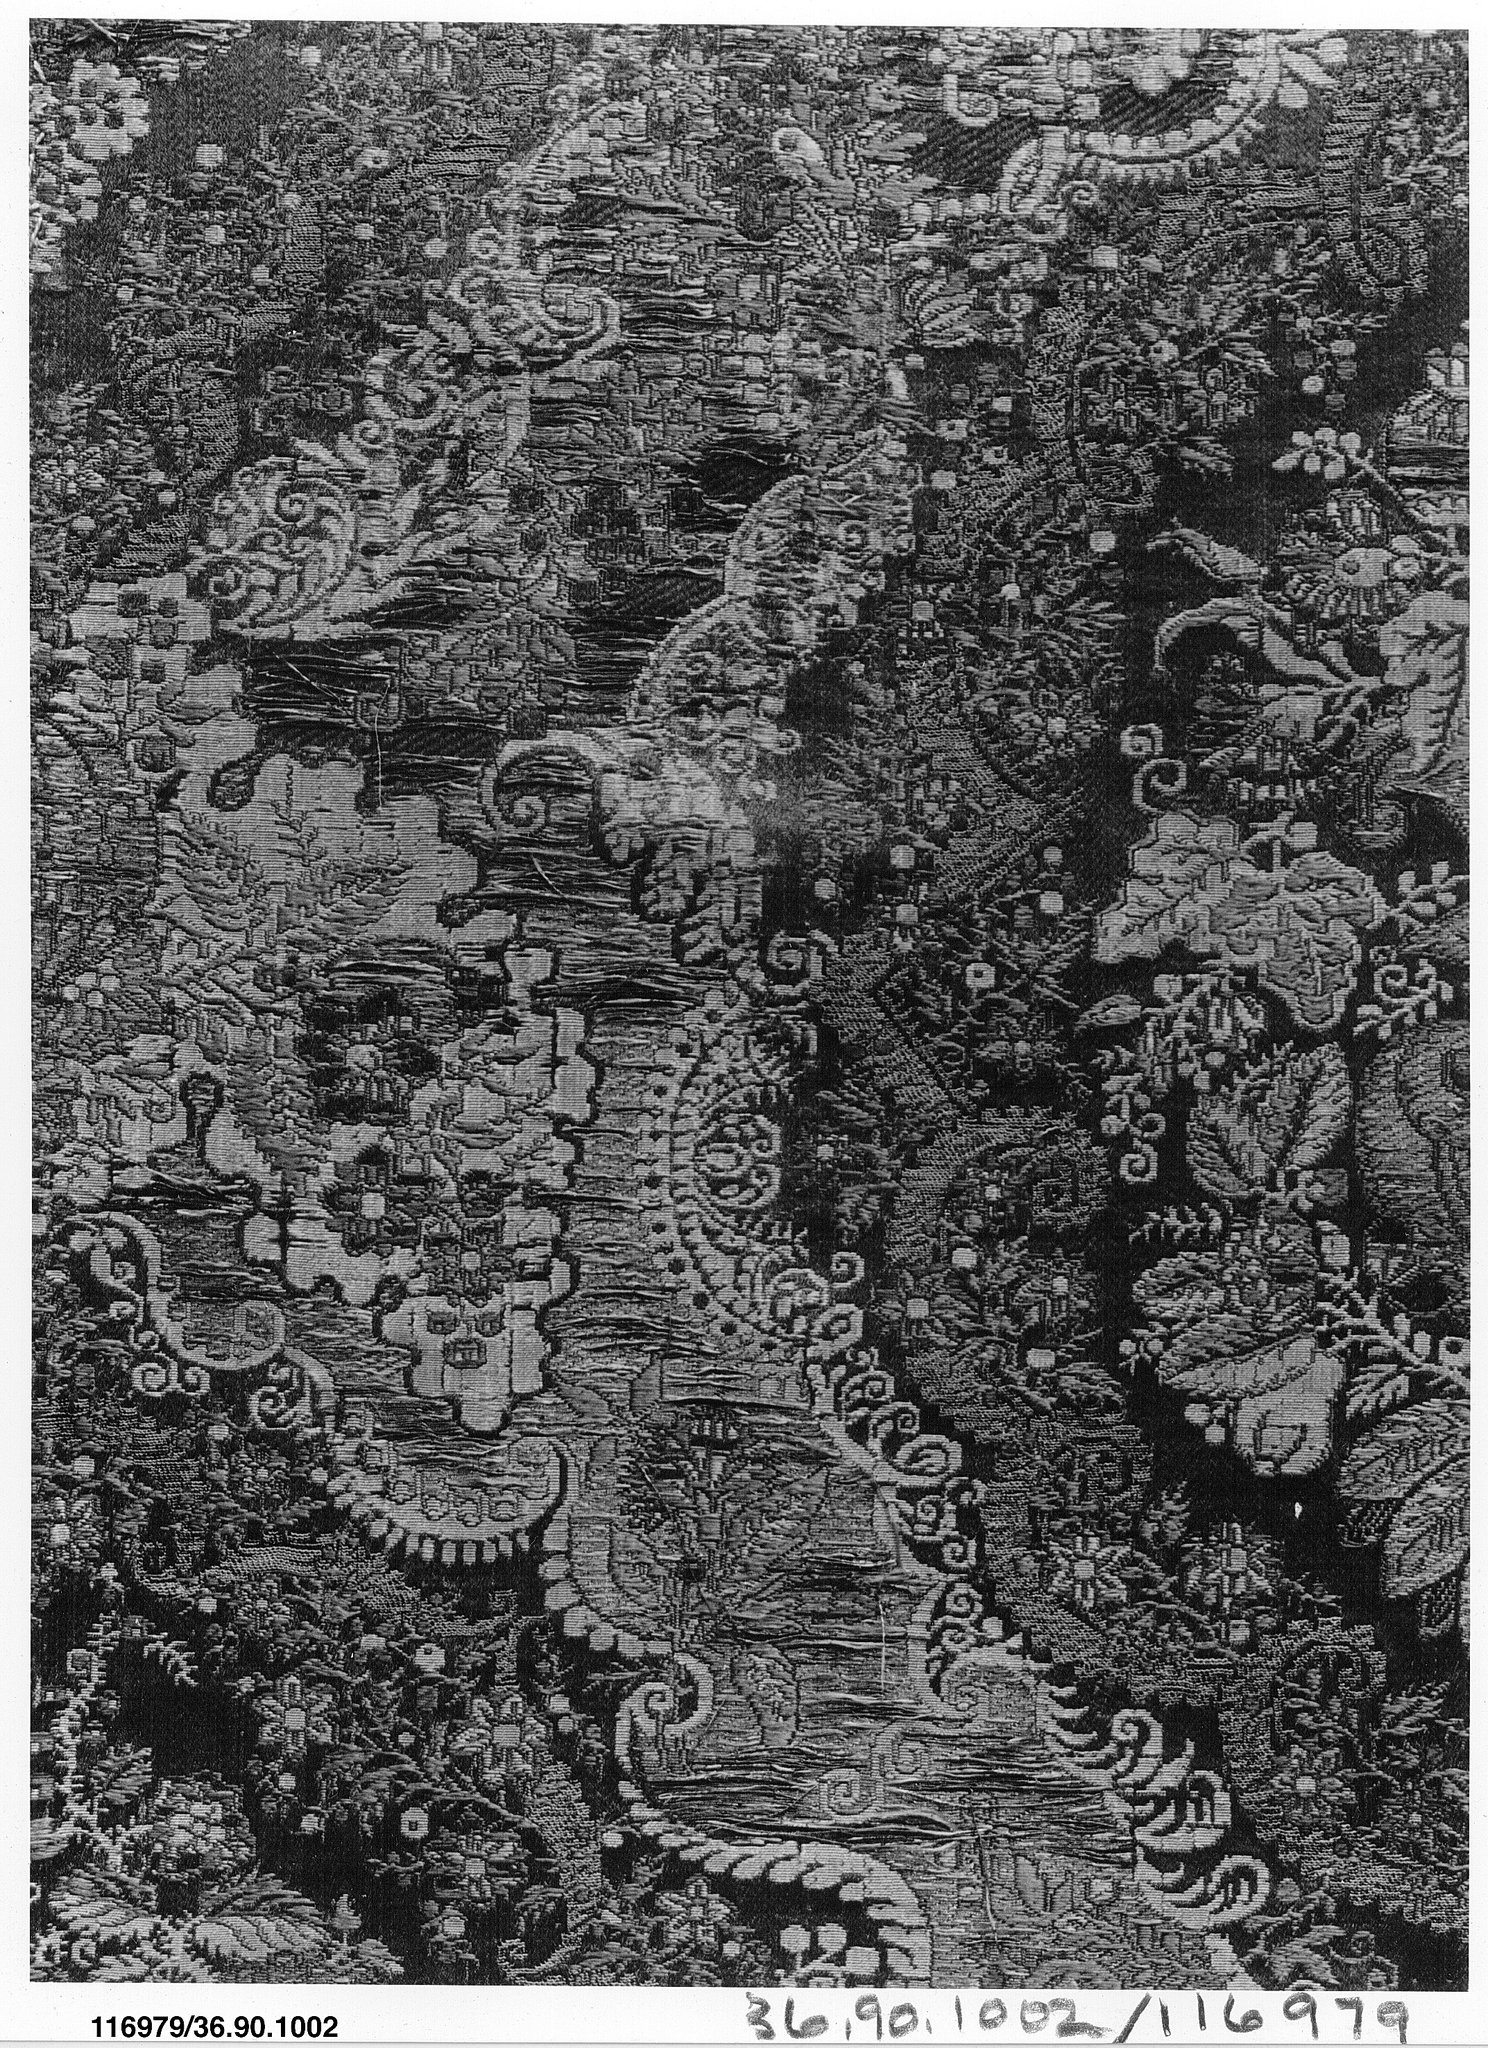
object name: piece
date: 1701-1900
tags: flowers,leaves